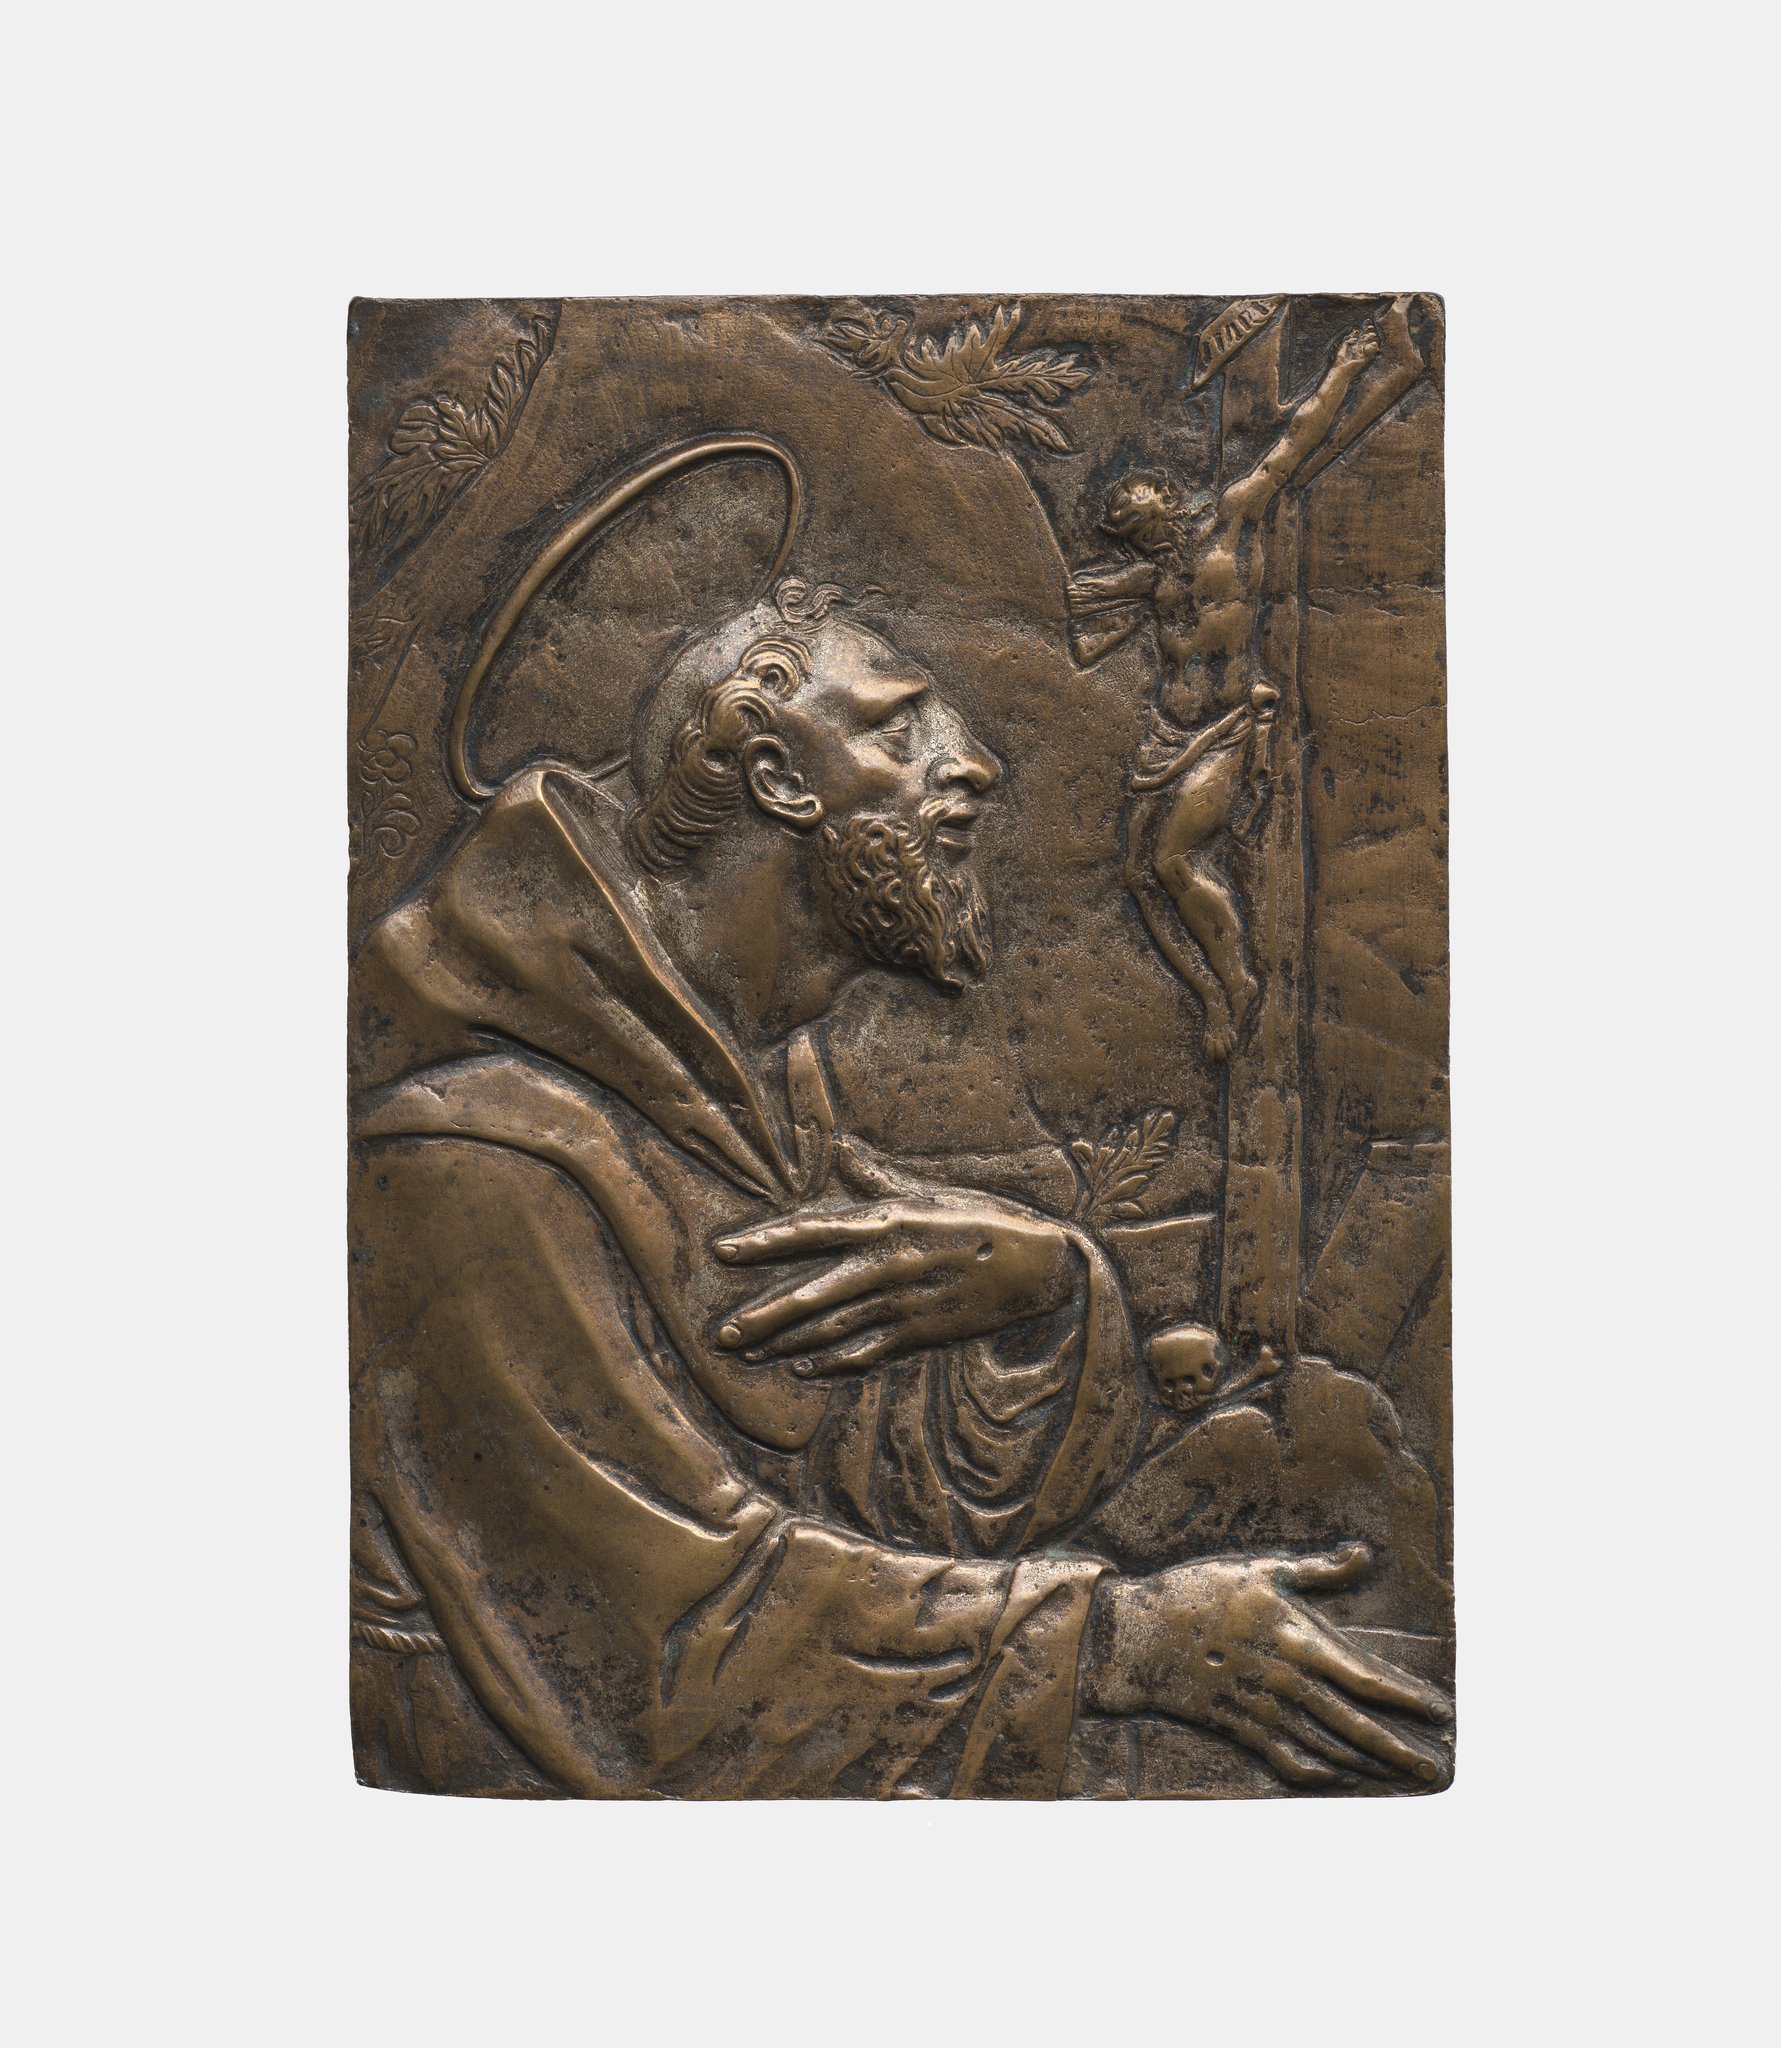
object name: plaquette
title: St. Francis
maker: Anonymous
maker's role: artist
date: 1600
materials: bronze, silver